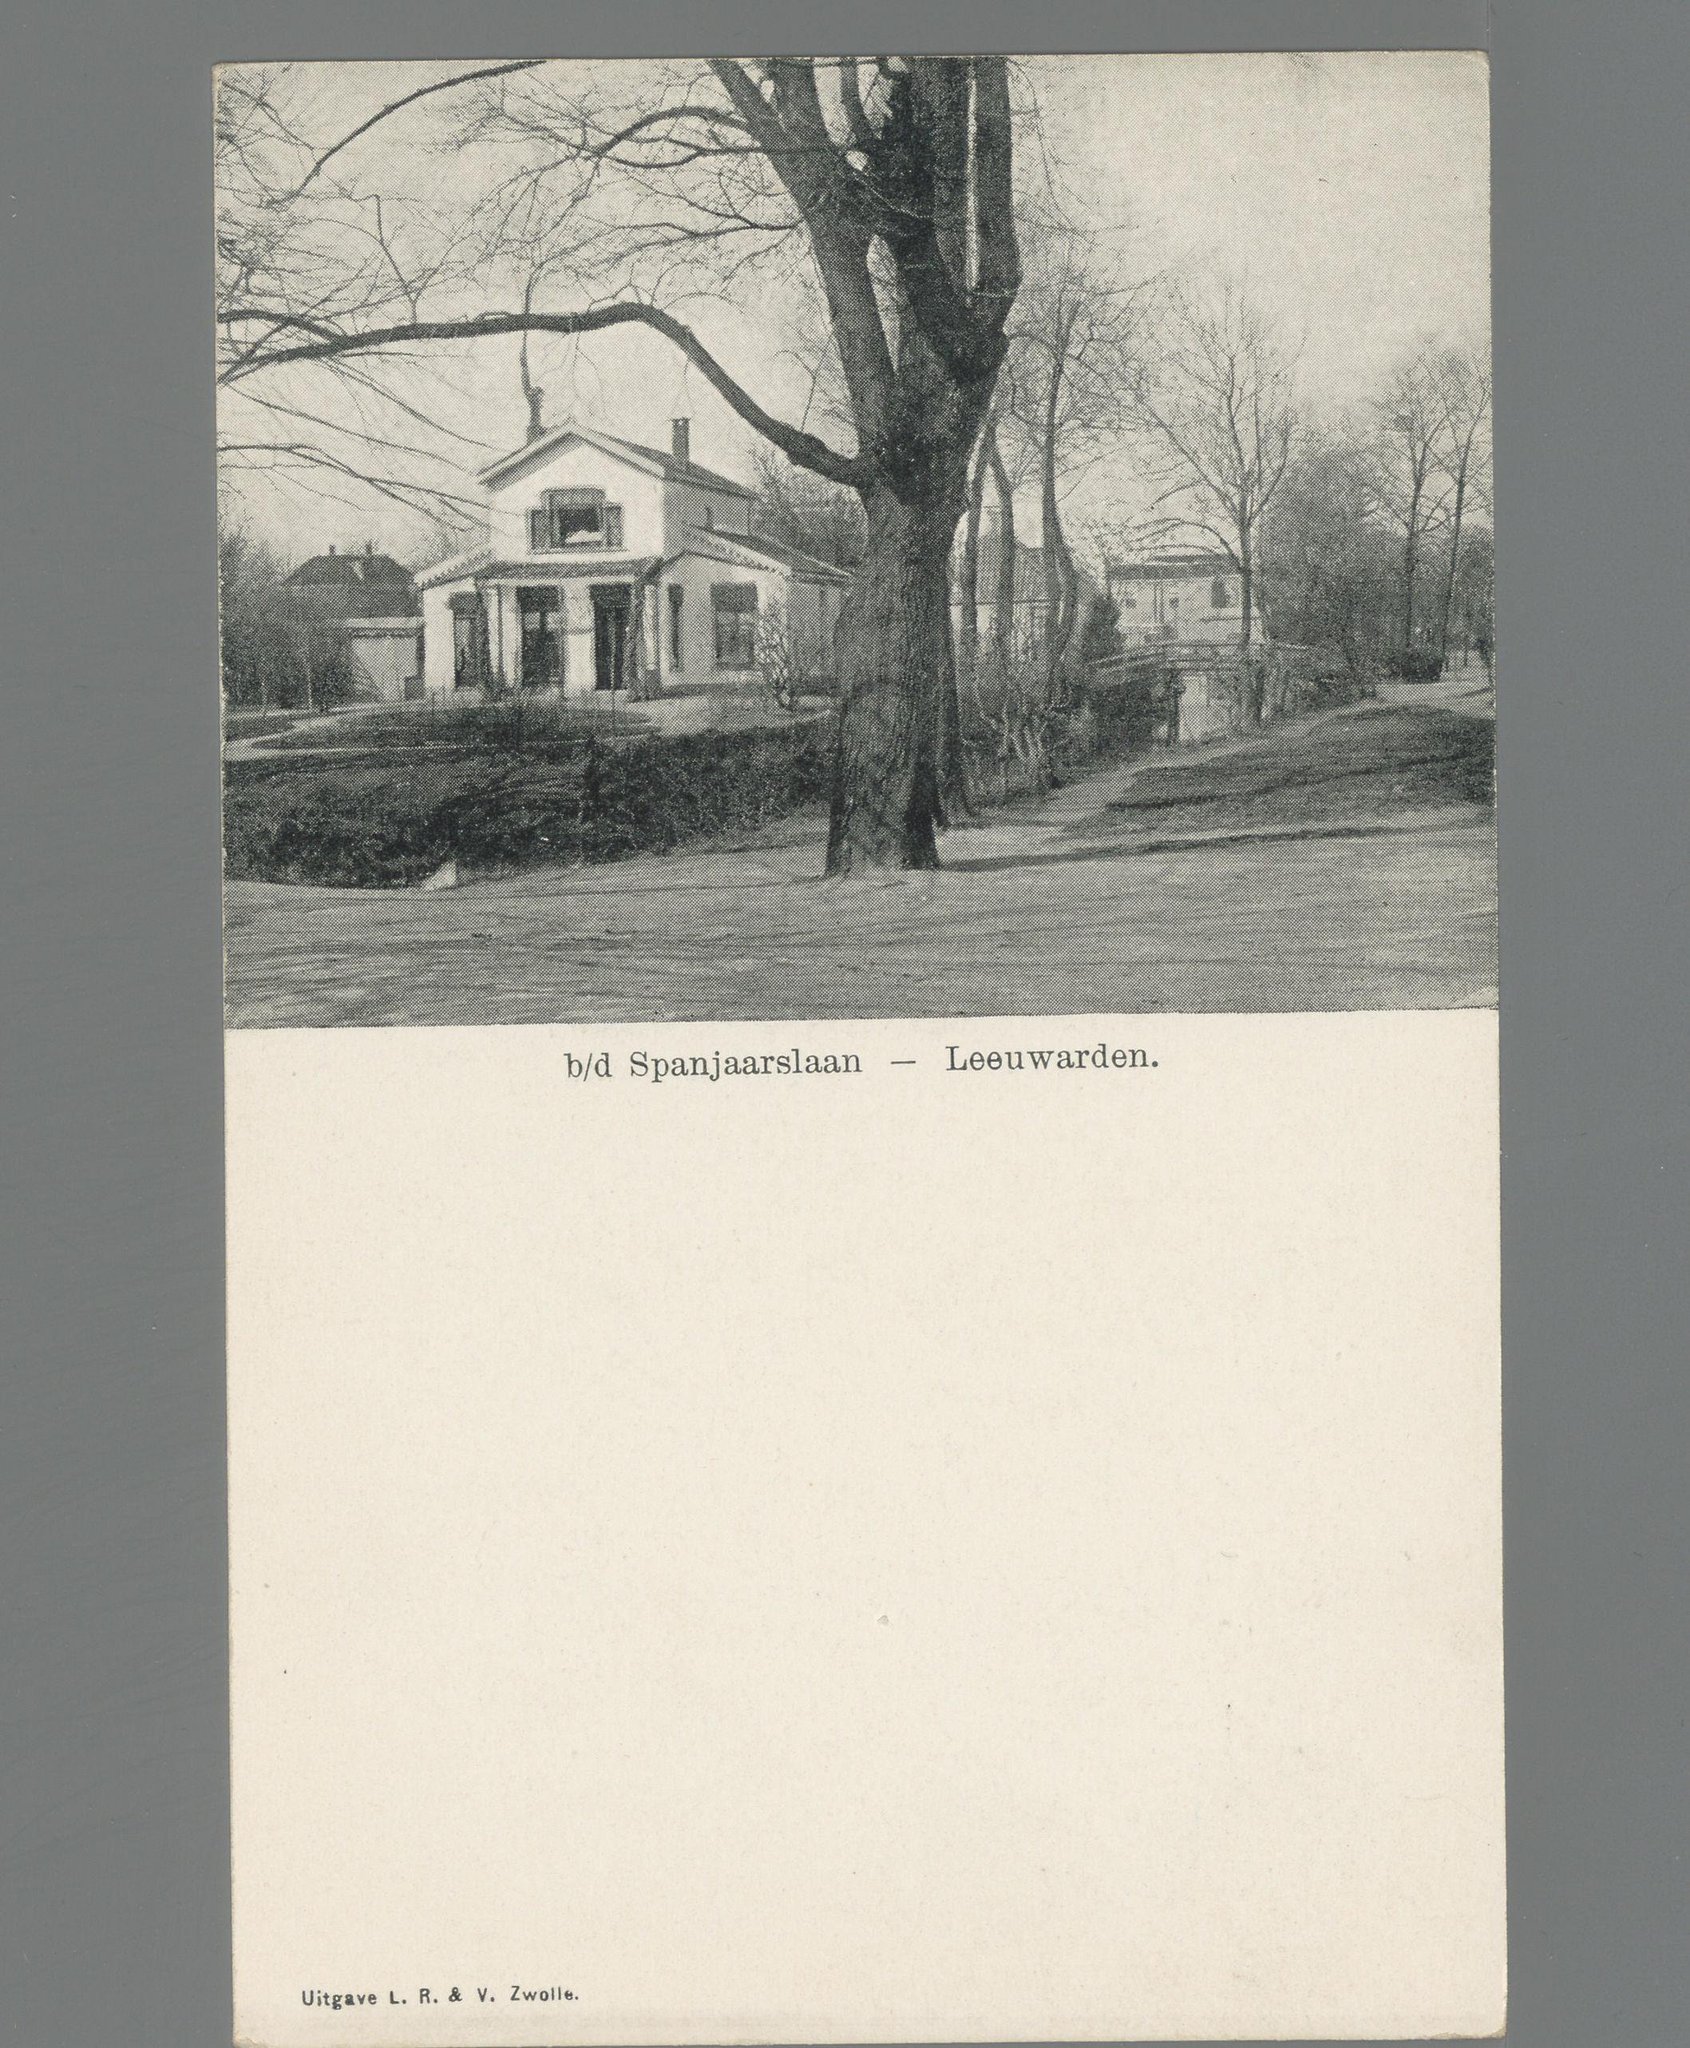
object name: photomechanical print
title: b/d Spanjaarslaan - Leeuwarden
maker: Anonymous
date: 1897-1905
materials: cardboard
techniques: autotype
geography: leeuwarden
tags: trees, street